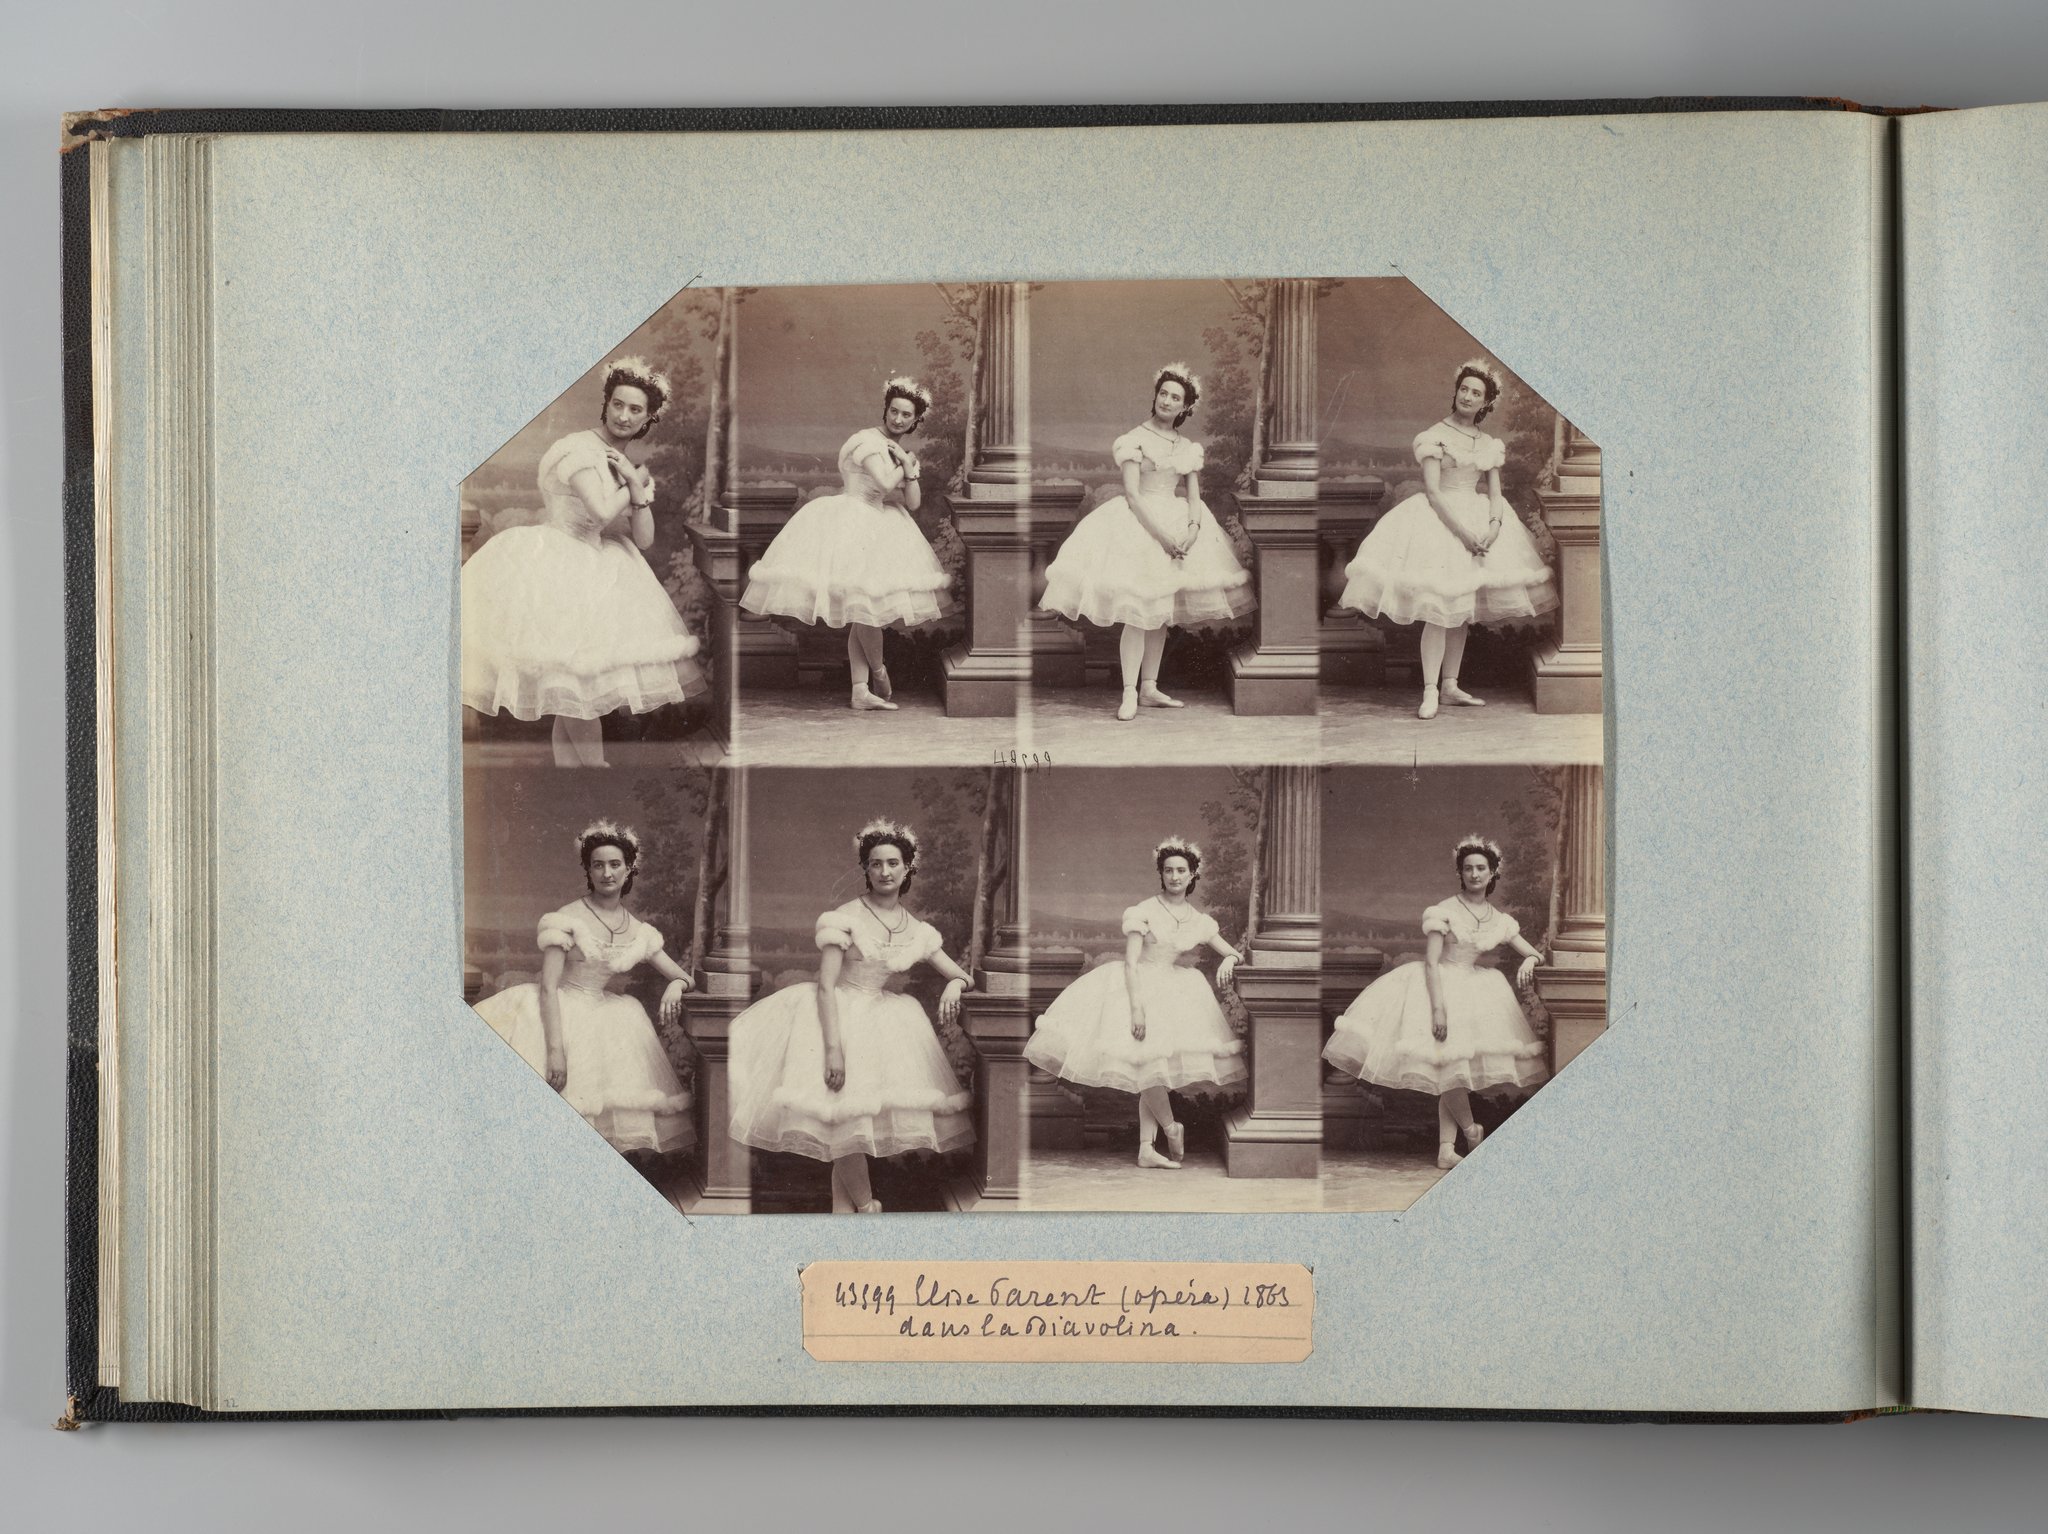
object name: photograph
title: Elise Parent dans la Diavolina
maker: andré-adolphe-eugène disdéri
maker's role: artist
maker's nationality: french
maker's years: 1819-1889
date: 1863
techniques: albumen silver print, glass negative